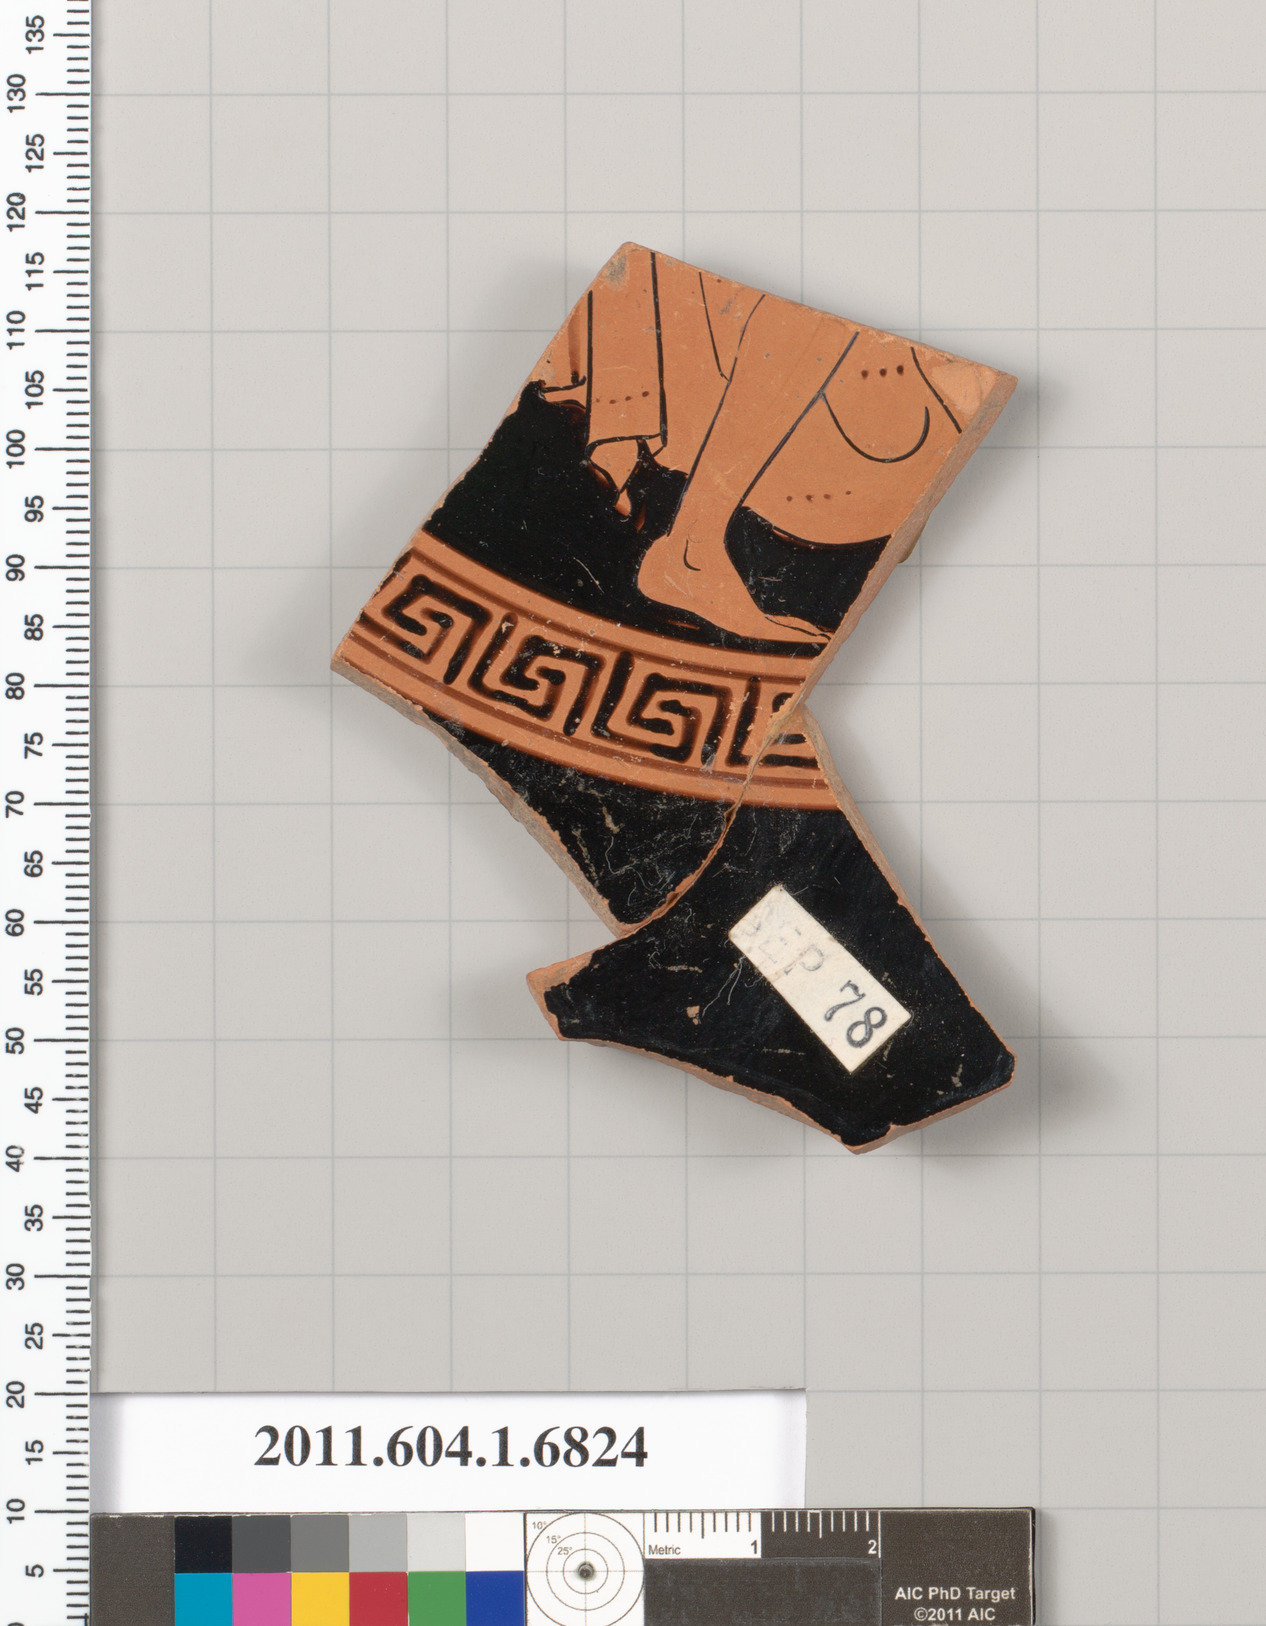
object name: kylix fragment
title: Terracotta fragment of a kylix (drinking cup)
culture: greek, attic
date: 490-470 BCE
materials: terracotta